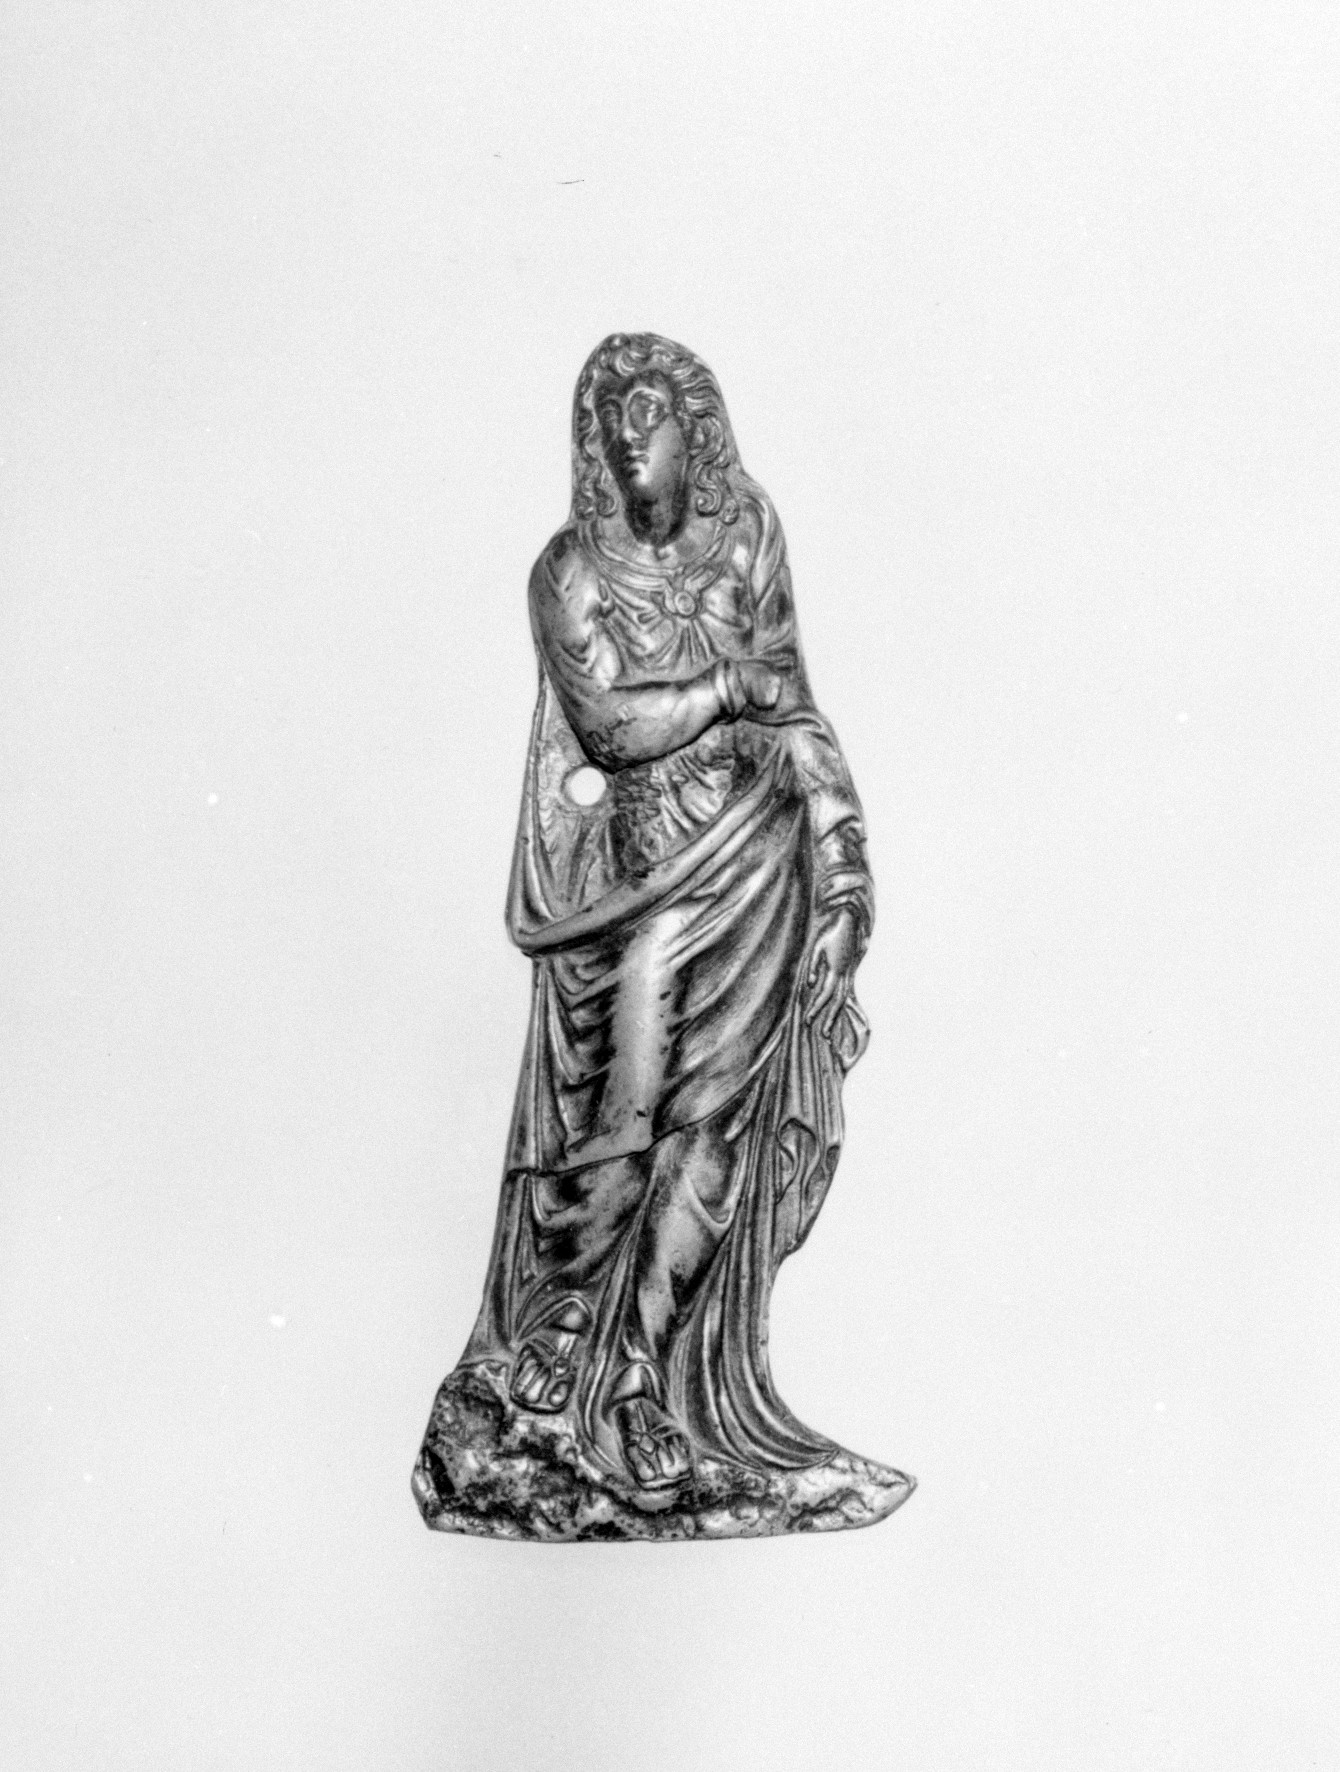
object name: relief figure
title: Mourning St. John from a Crucifixion Group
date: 1501-1600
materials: bronze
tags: saints